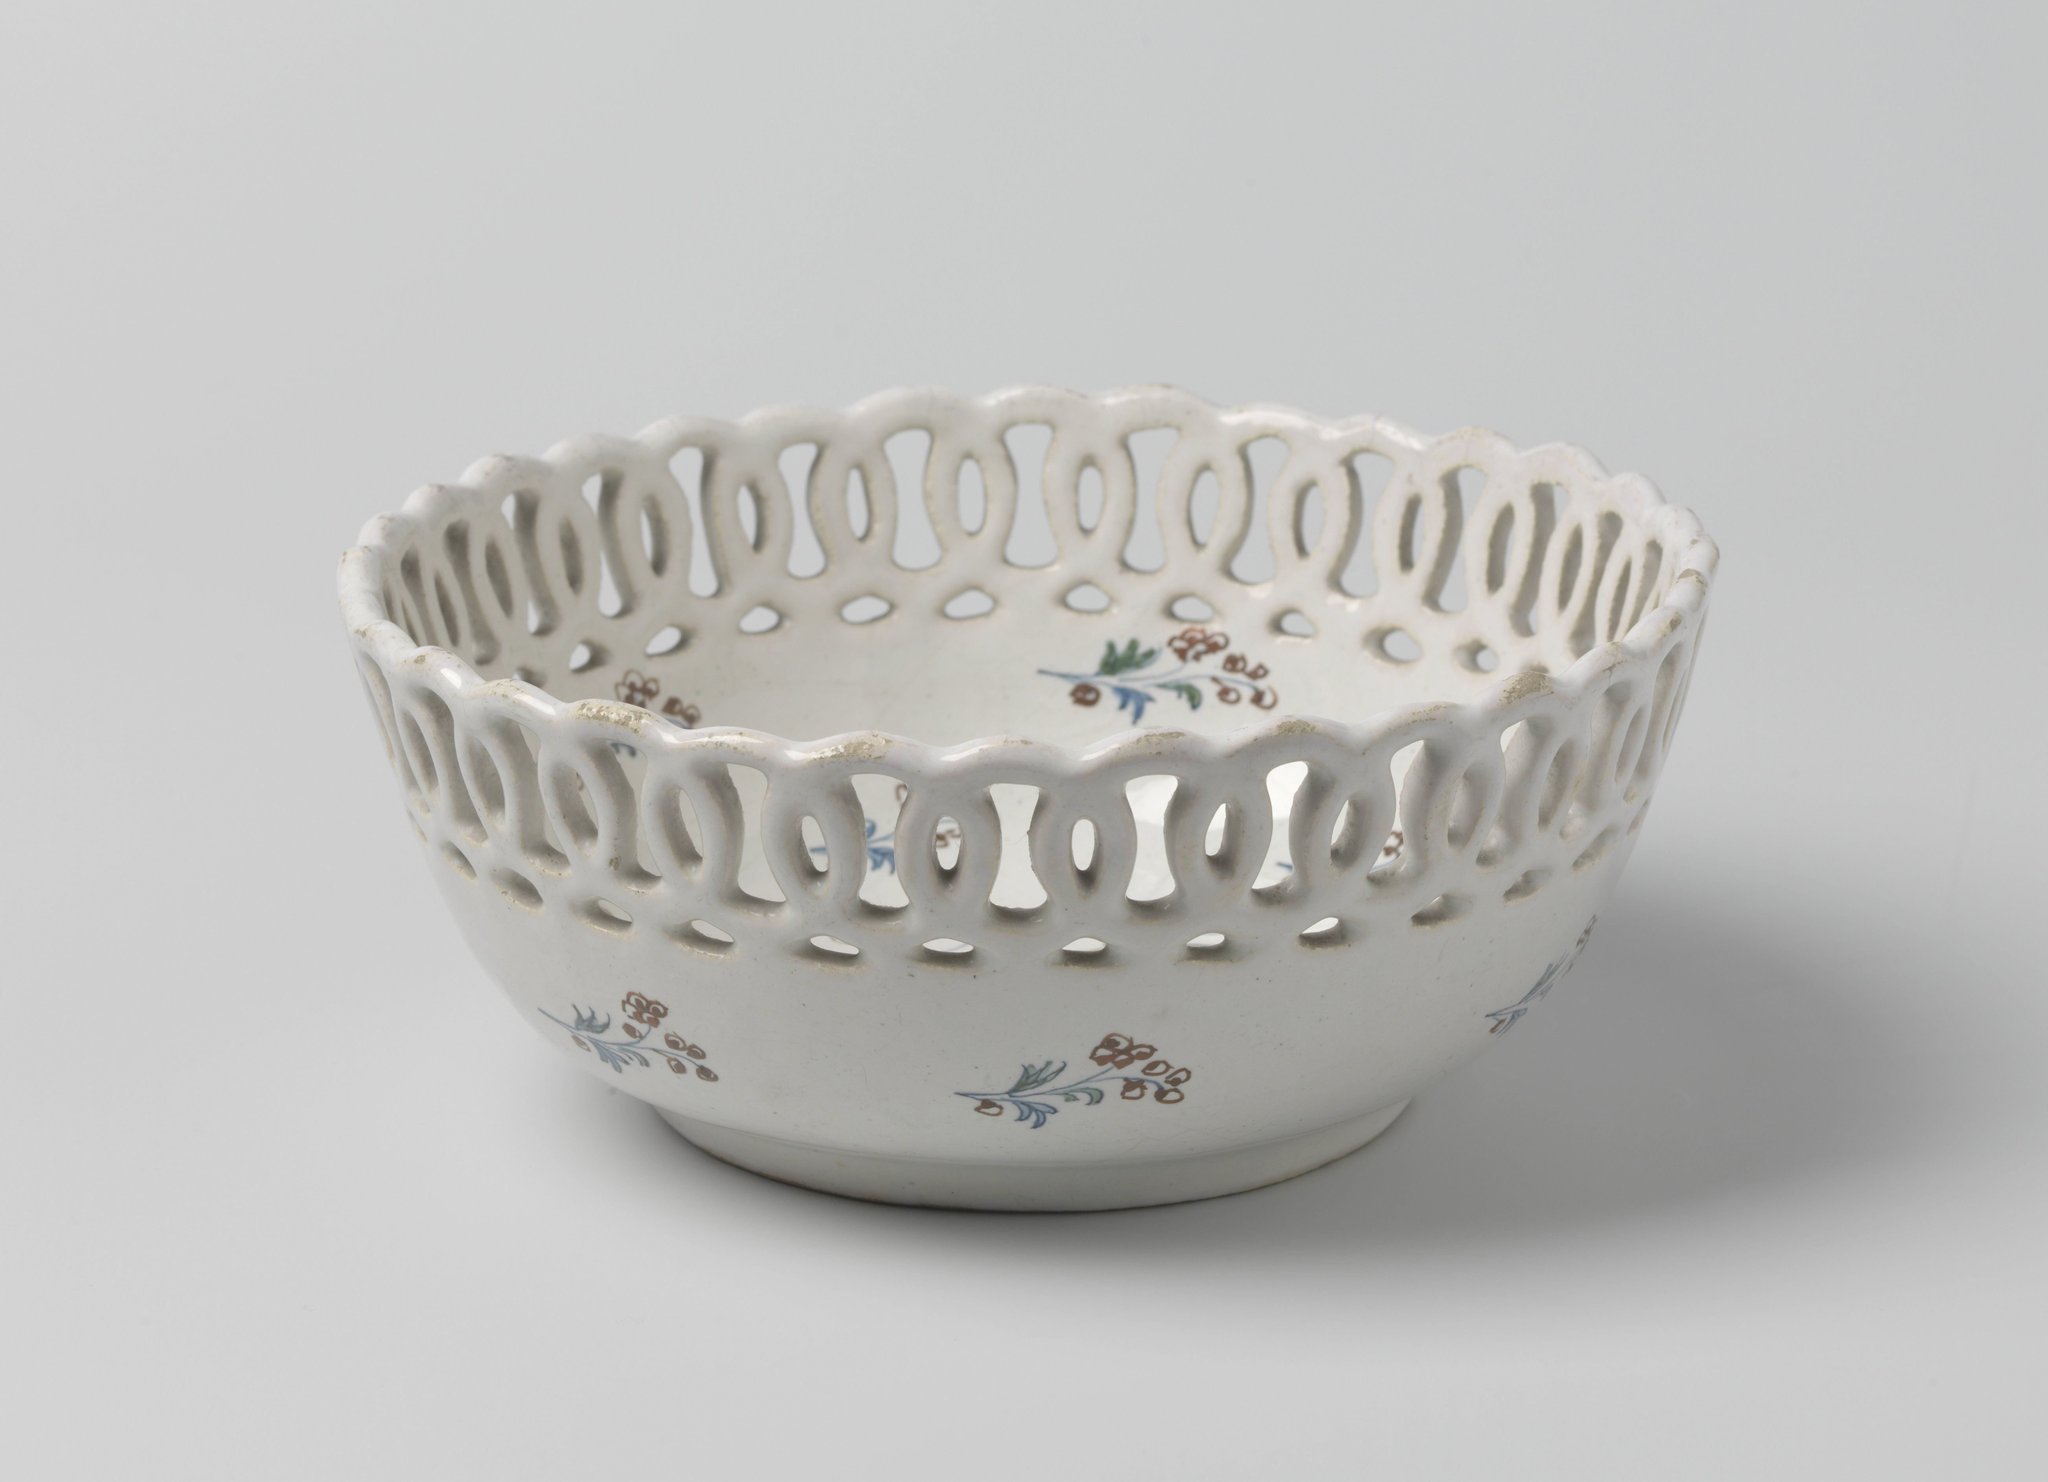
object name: bowl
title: Fruitbak of kom van aardewerk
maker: Anonymous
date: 1400-1950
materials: earthenware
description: Aardewerken fruitbak of kom. Rouaans met gekleurde bloemen en ajour rand.